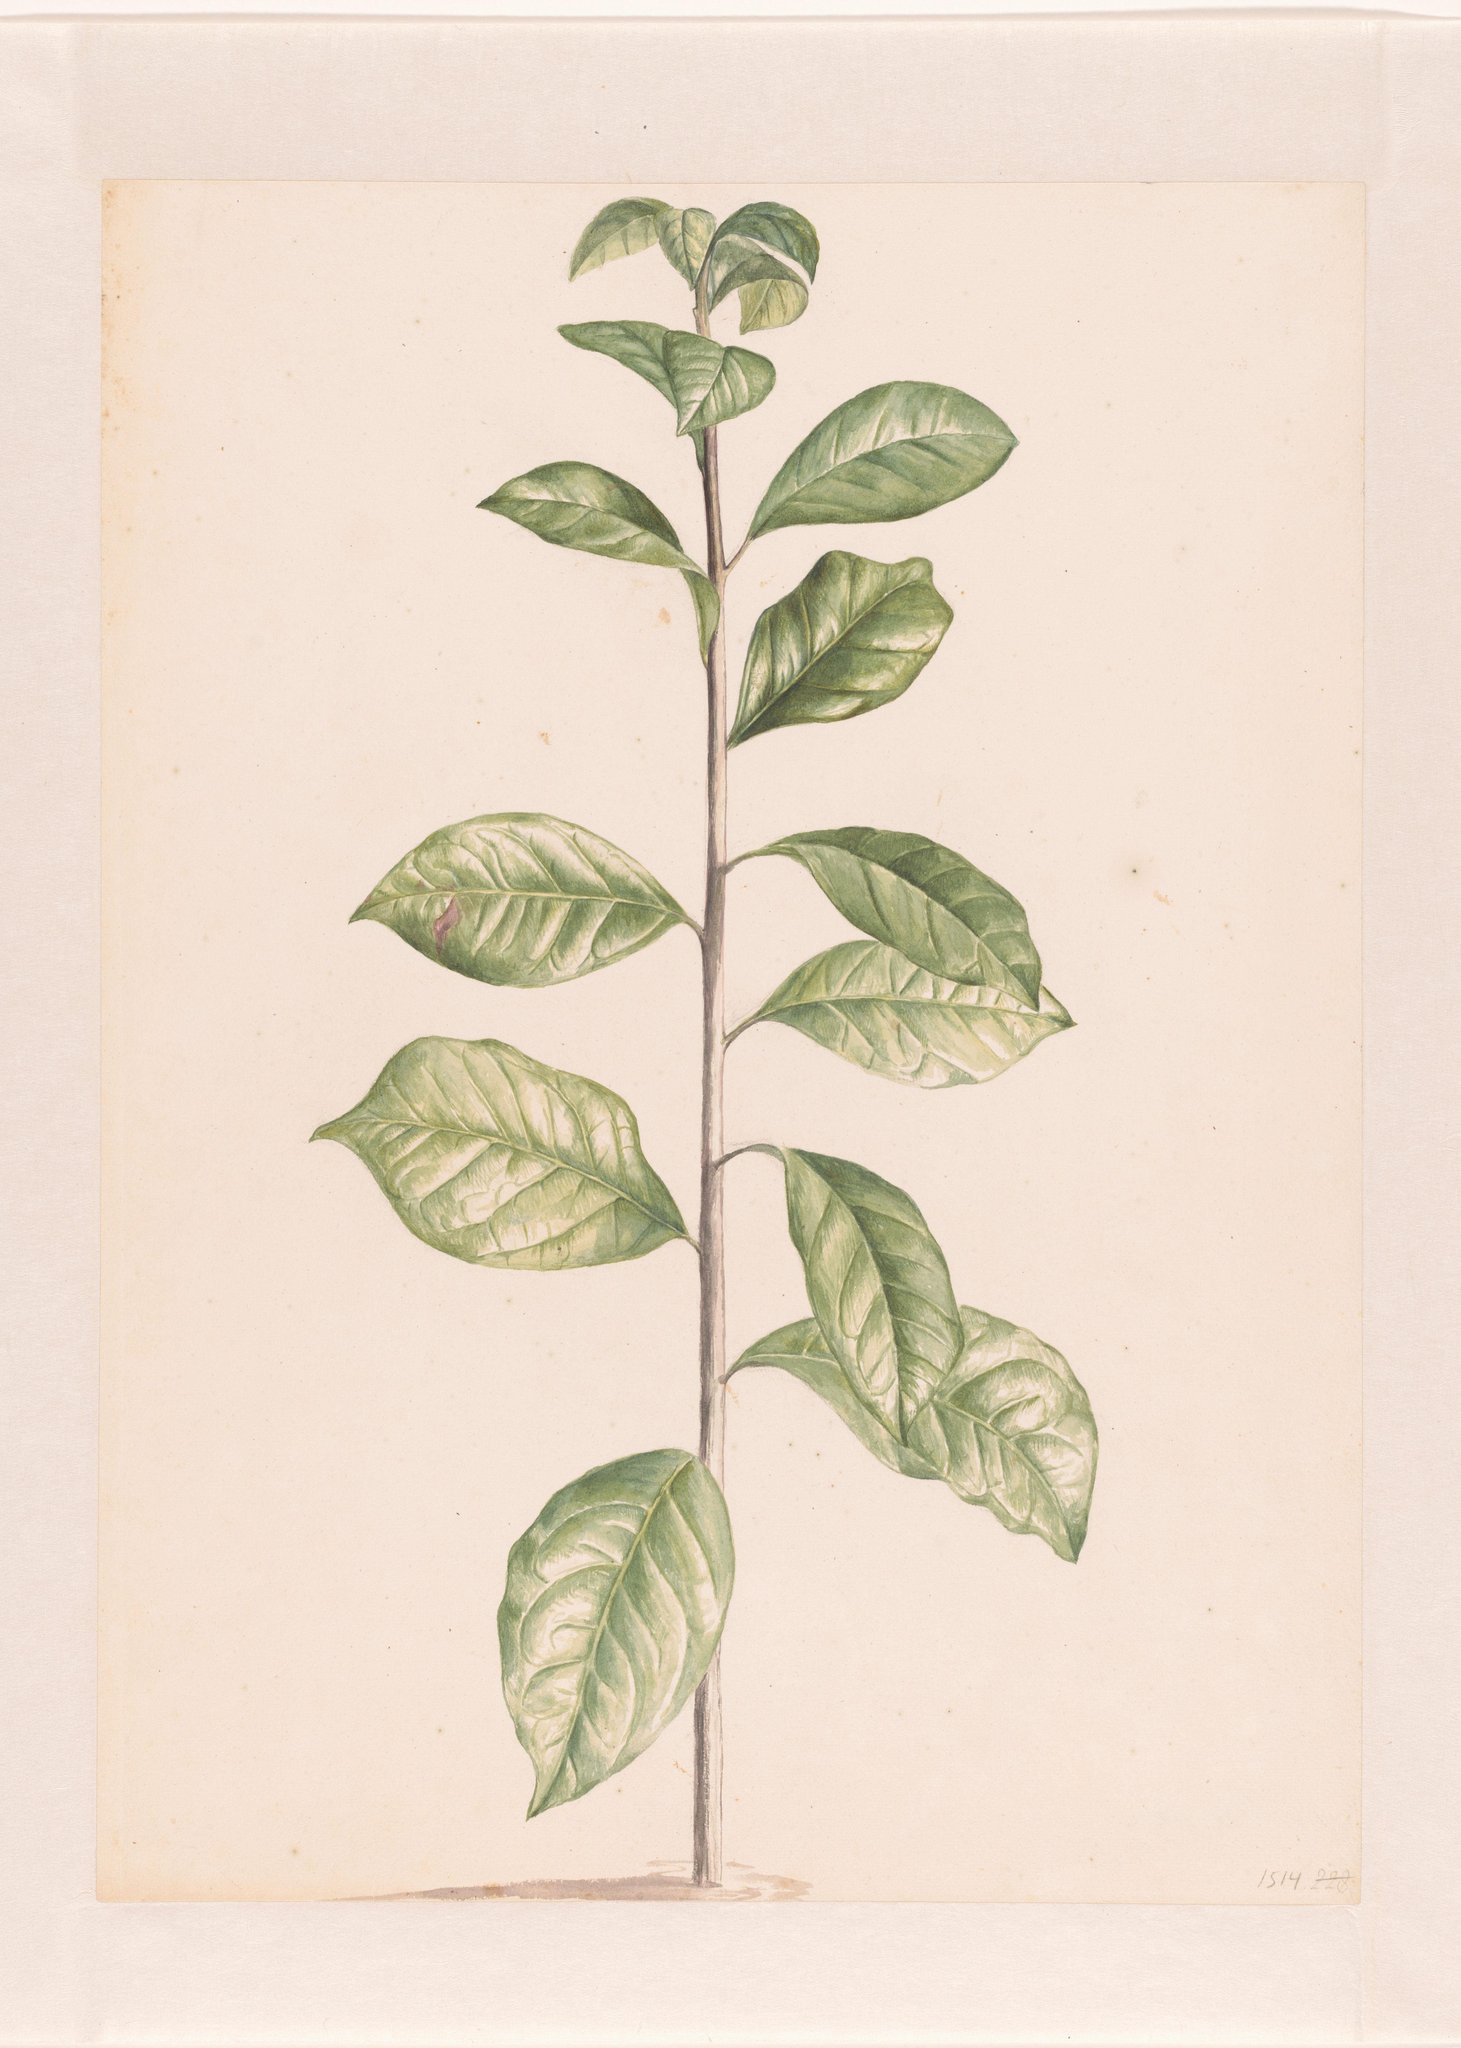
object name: drawing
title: Arabische koffieplant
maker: laurens vincentsz. van der vinne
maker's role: draughtsman, print maker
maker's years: 1658-1729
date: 1668-1729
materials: paint, paper, pencil, watercolor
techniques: brush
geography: netherlands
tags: fruits: coffee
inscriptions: inscription: ‘Coffea arabica’